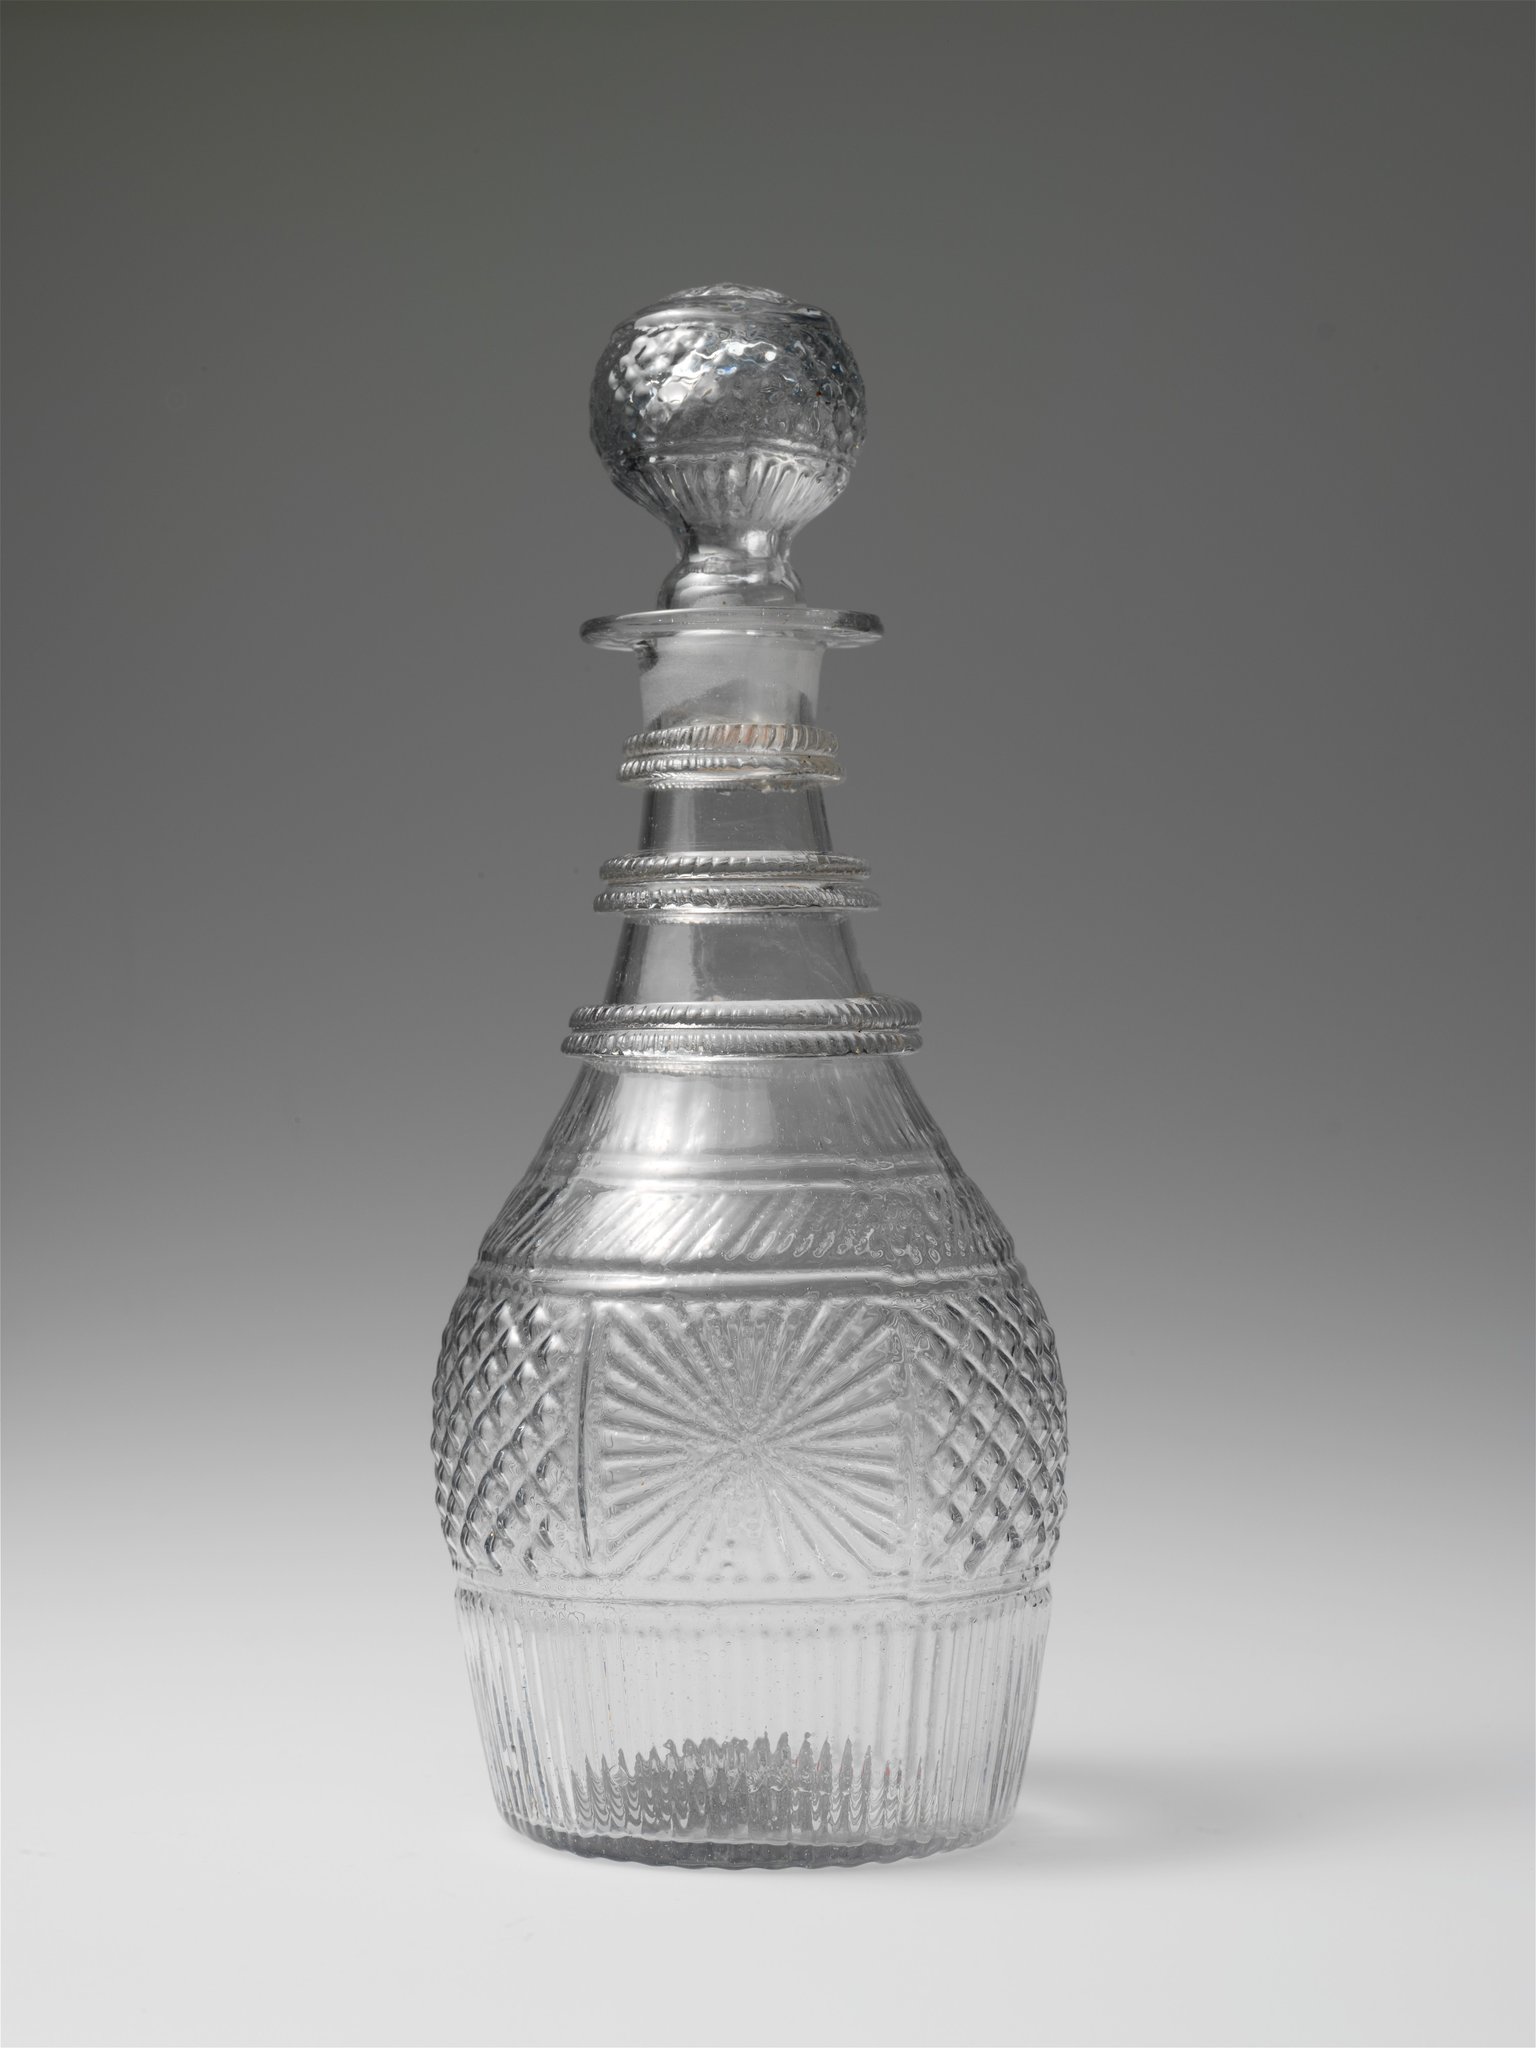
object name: decanter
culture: american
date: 1815-1840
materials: glass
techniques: glassblowing, molding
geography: united states